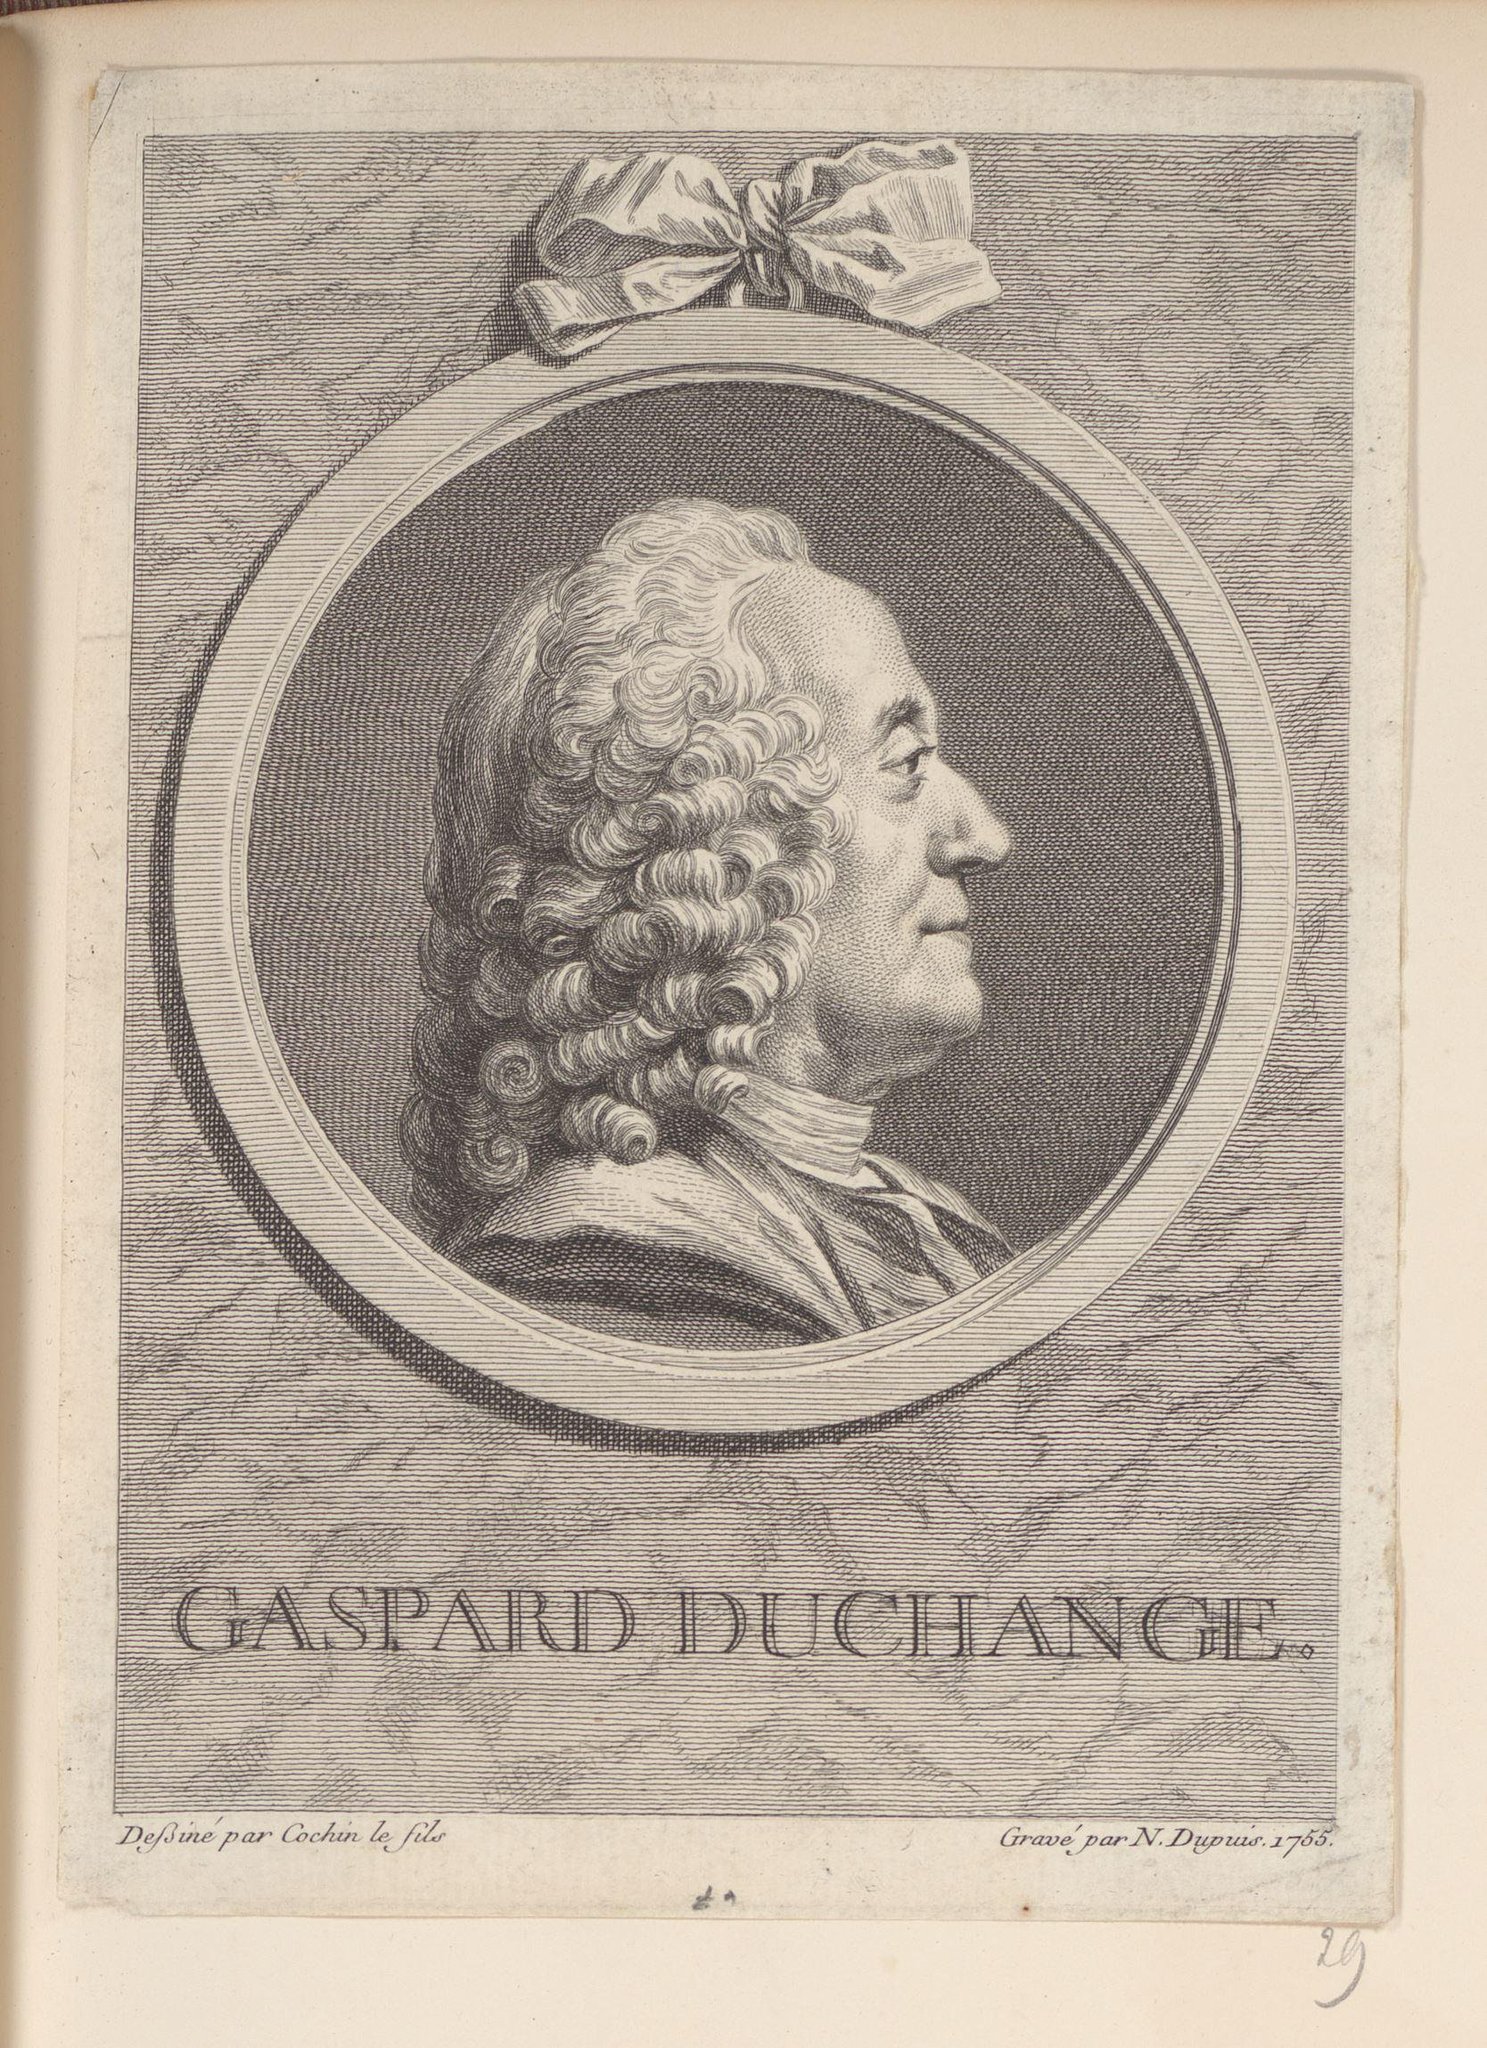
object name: album leaf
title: Portret van Gaspard Duchange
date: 1755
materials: paper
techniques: engraving, etching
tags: paris, print maker, publisher, gaspard duchange, historical persons, portrait, self-portrait of graphic artist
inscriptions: date